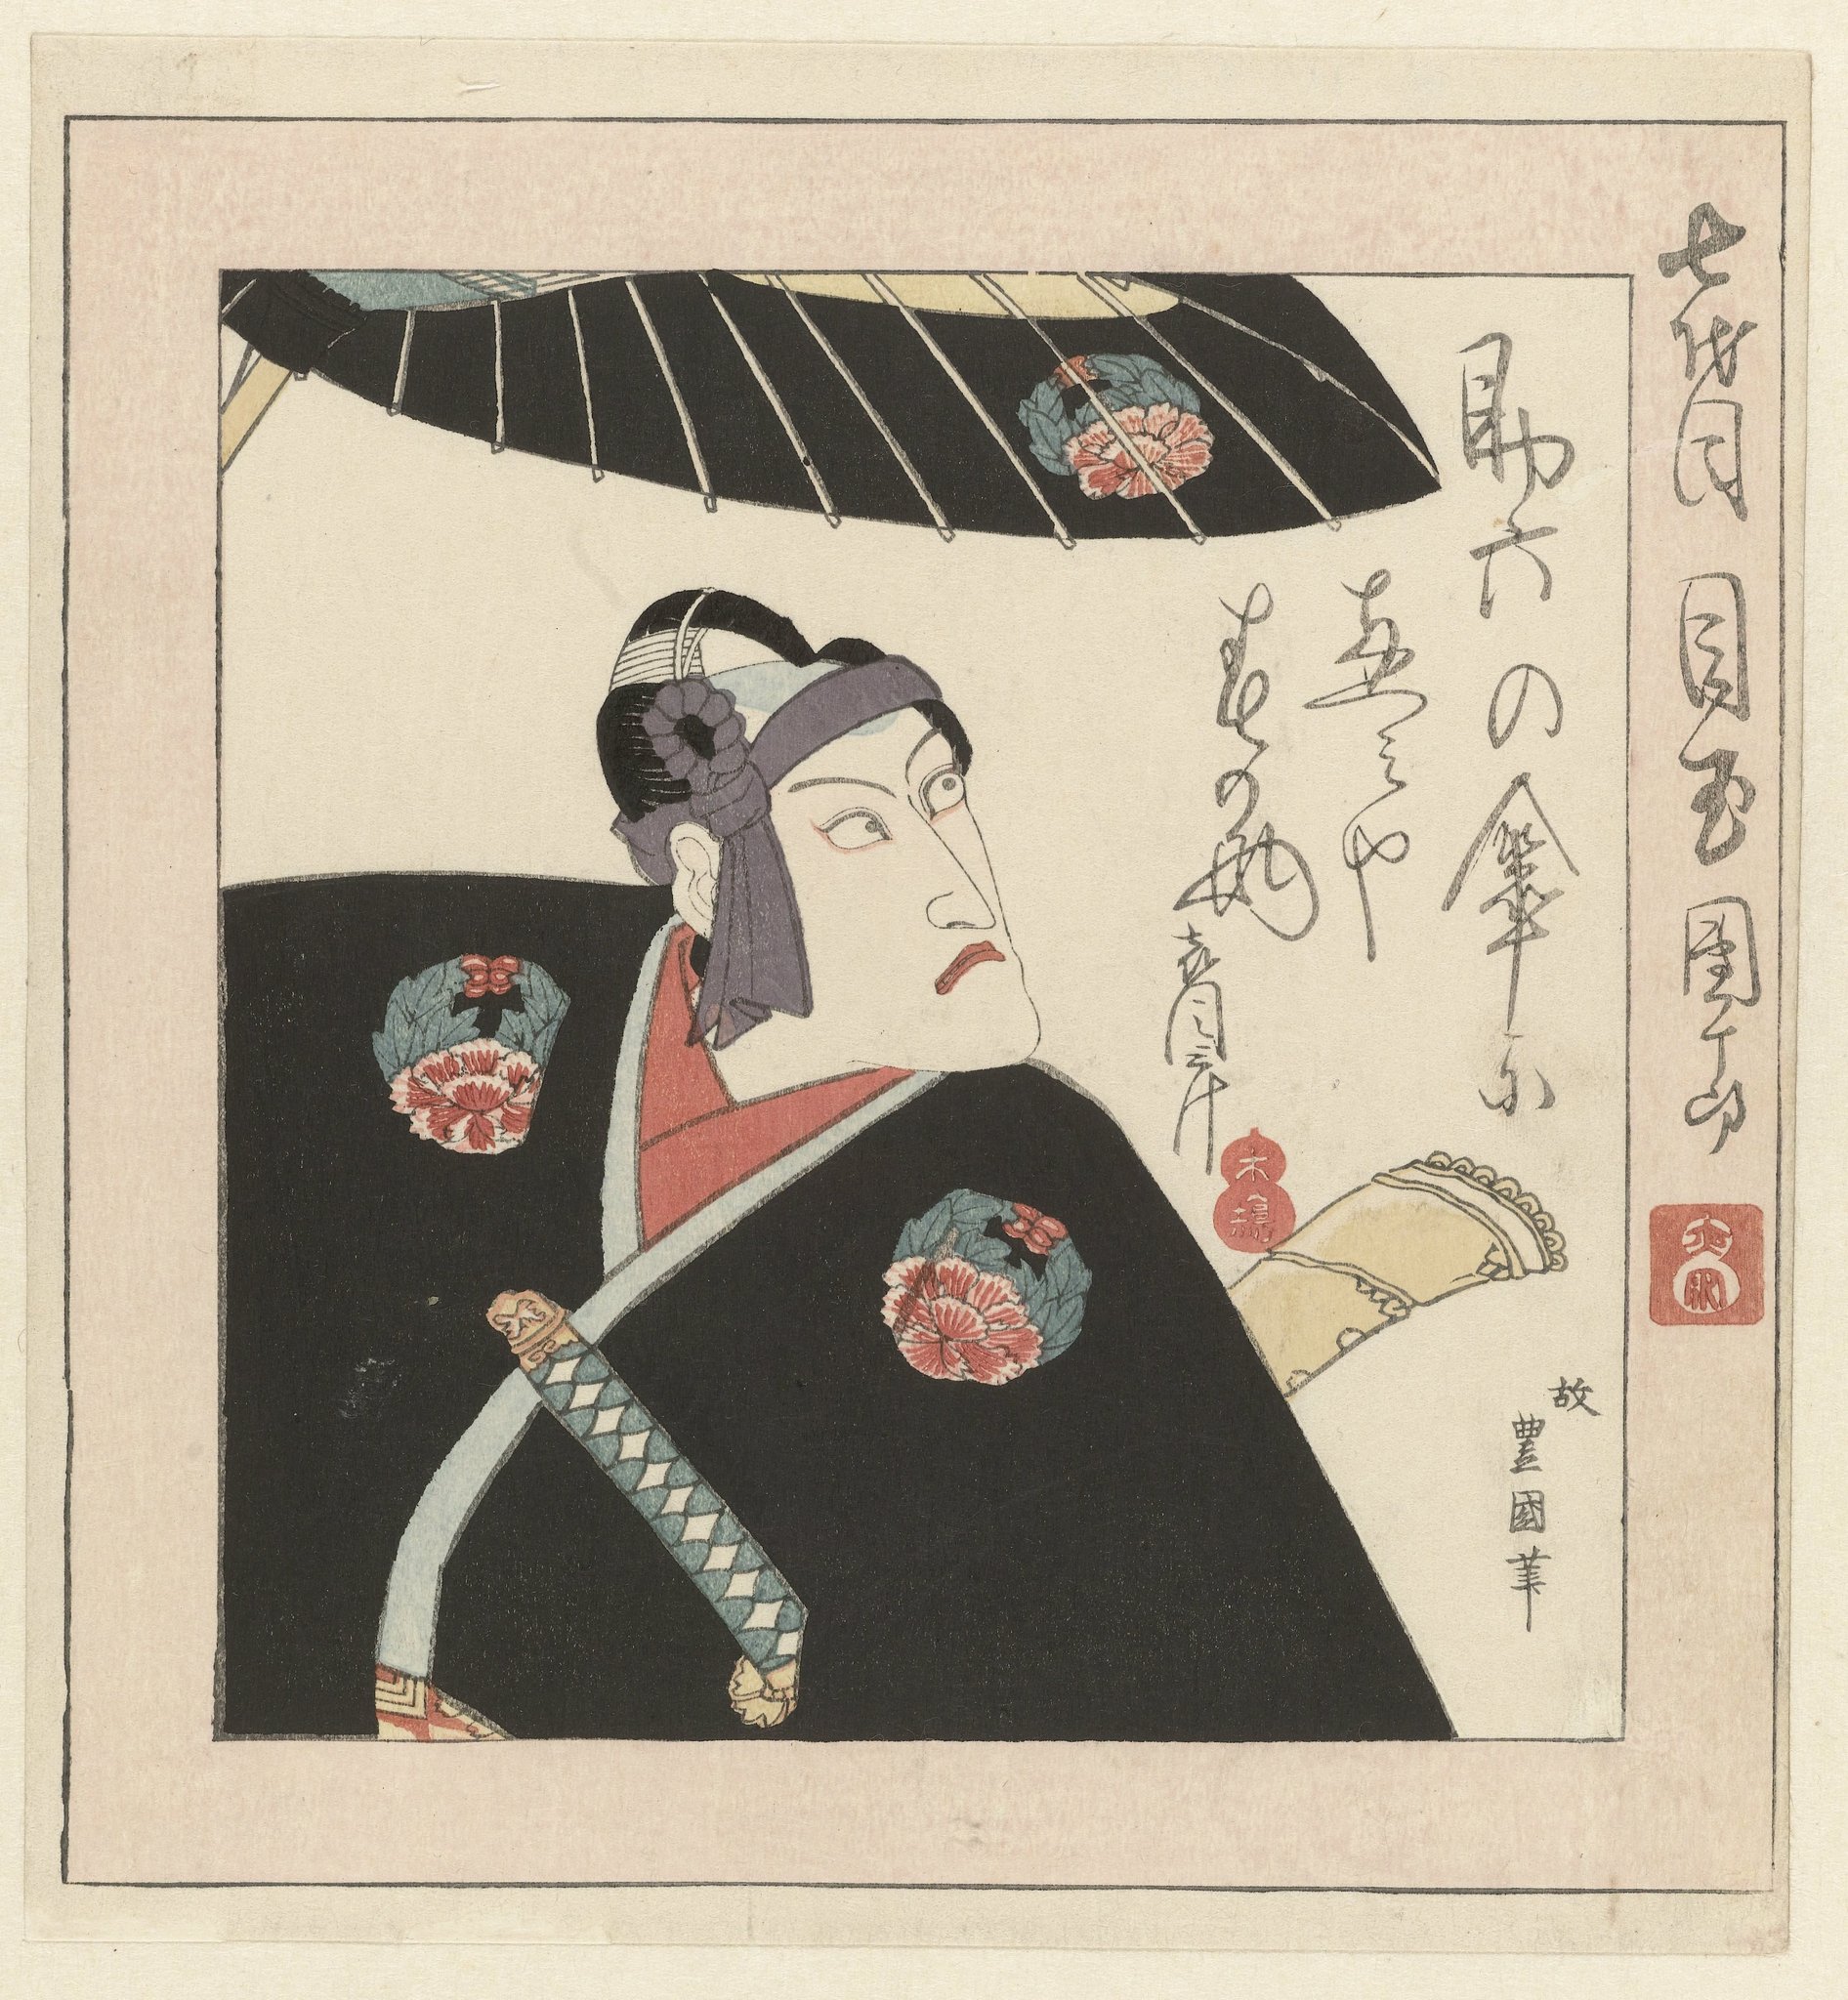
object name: print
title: The Kabuki Actor Ichikawa Danjûrô VII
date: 1825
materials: paper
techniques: woodcut, polish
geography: japan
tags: portrait of actor, actress, parasol, sunshade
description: Een surimono is een luxe uitgevoerde prent waarop beeld met één of meerdere gedichten gecombineerd is. Bij het drukken van een surimono werd vaak gebruik gemaakt van dikker papier, blinddruk en metaal pigmenten, zoals koper- en zilverpoeder. De prenten werden vaak in opdracht van dichters gemaakt en als exclusief geschenk aan vrienden en relaties gegeven.